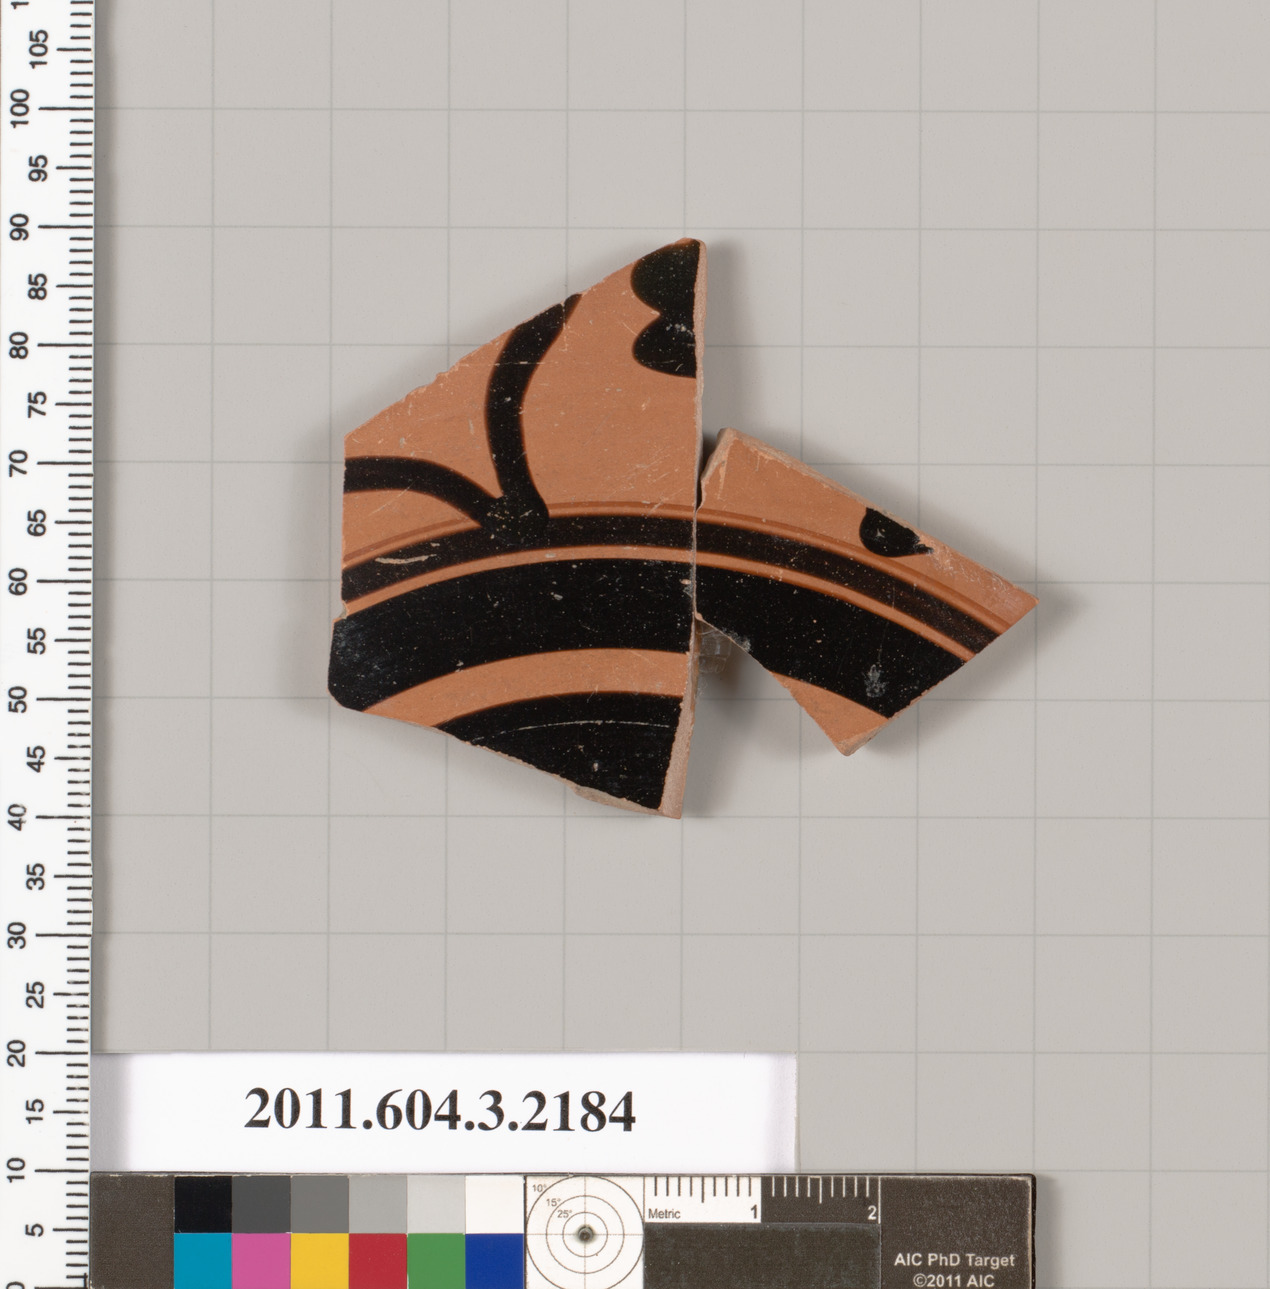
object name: kylix fragment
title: Terracotta fragment of a kylix (drinking cup)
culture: greek, attic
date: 500-468 BCE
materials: terracotta